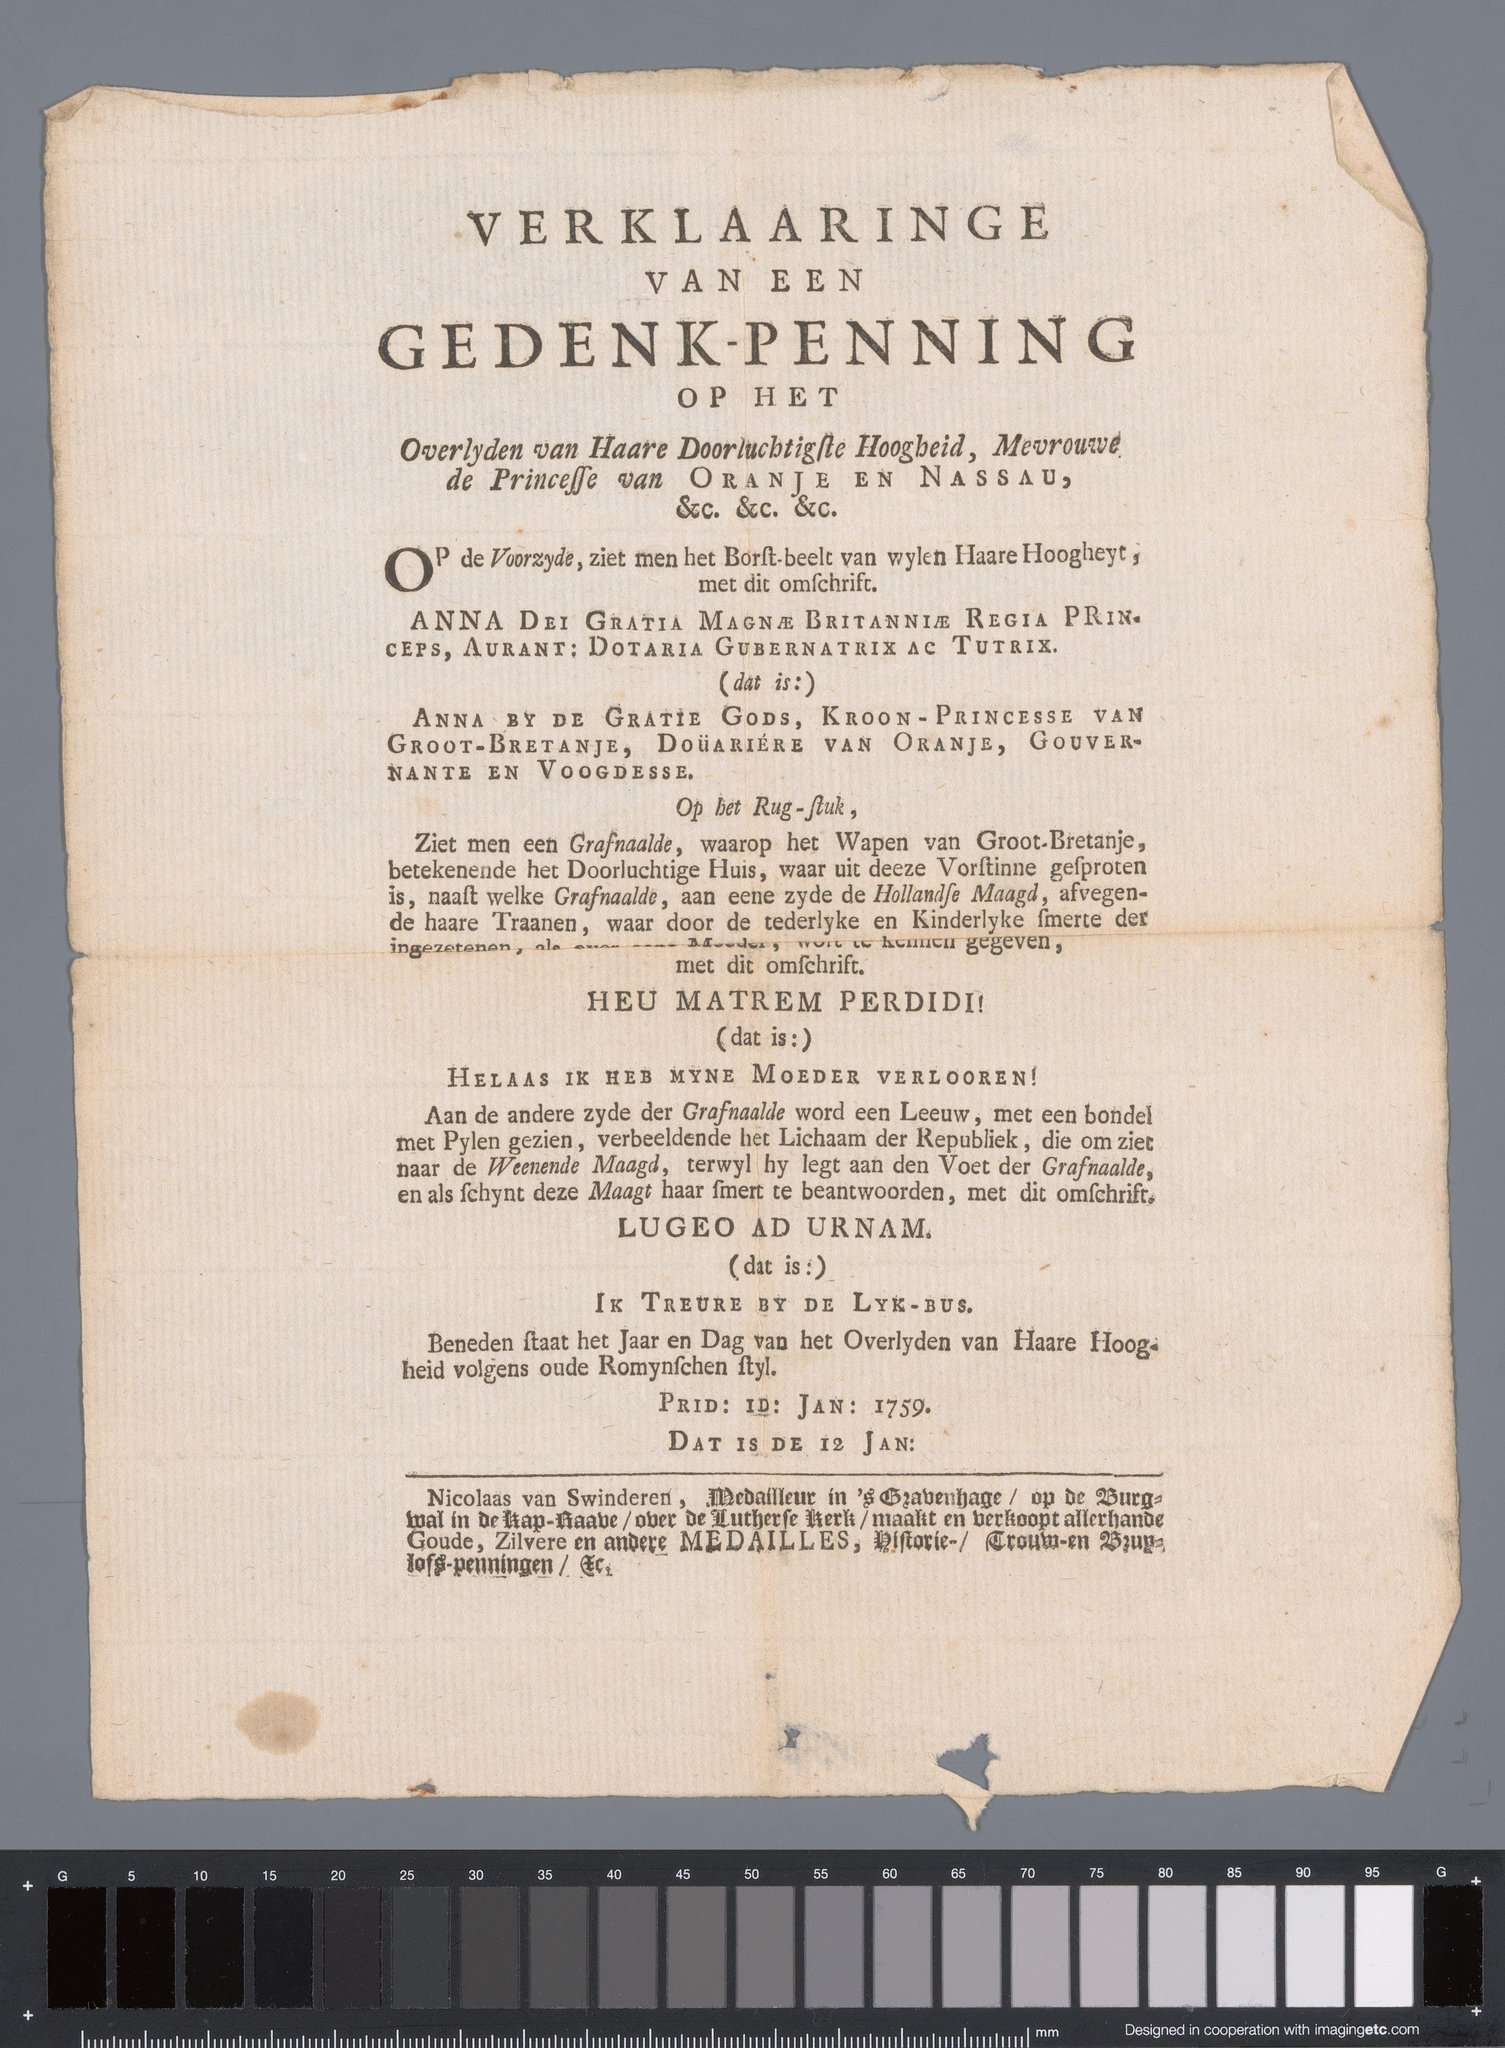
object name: pamphlet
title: Verklaring van de penning door Nikolaas van Swinderen geslagen op het overlijden van Anna van Hannover, prinses van Oranje-Nassau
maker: Anonymous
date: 1759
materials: paper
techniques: printing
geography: the hague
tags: the hague, anna van hannover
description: eenzijdig, rechthoekig papier met opschrift, gedrukt in zwarte inkt